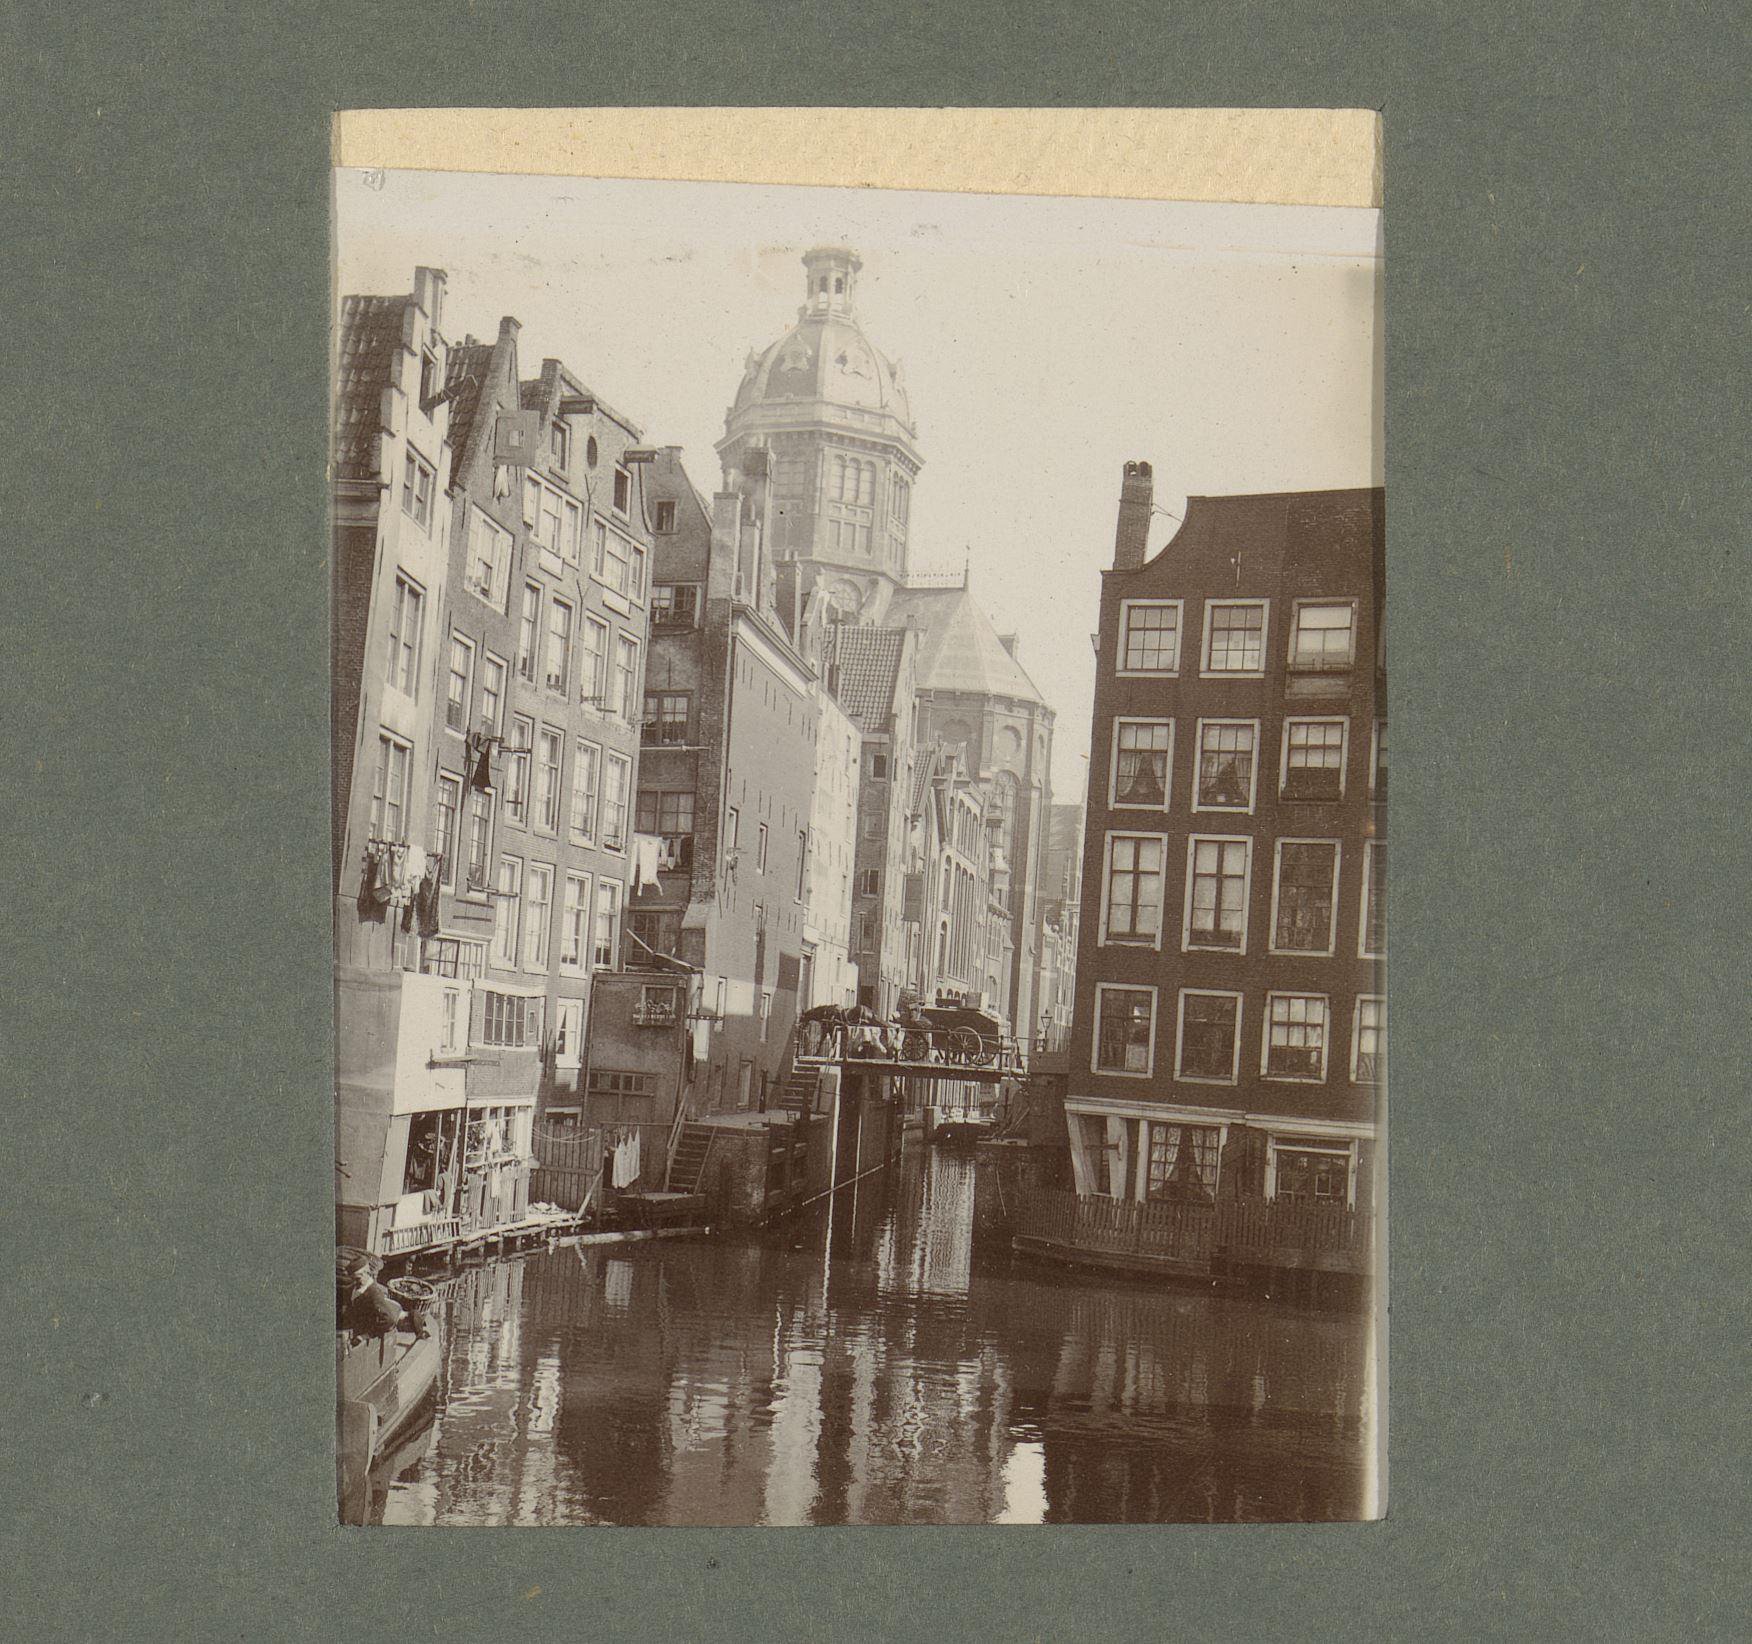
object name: photograph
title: Gezicht op de Nicolaaskerk te Amsterdam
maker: george hidderley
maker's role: fotograaf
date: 1920-1940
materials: photographic support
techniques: gelatin silver print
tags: city-view in general; 'veduta', canals, waters (in city)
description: Gezicht op de Nicolaaskerk en de Oudezijdskolk te Amsterdam. Deze foto maakt deel uit van een album.